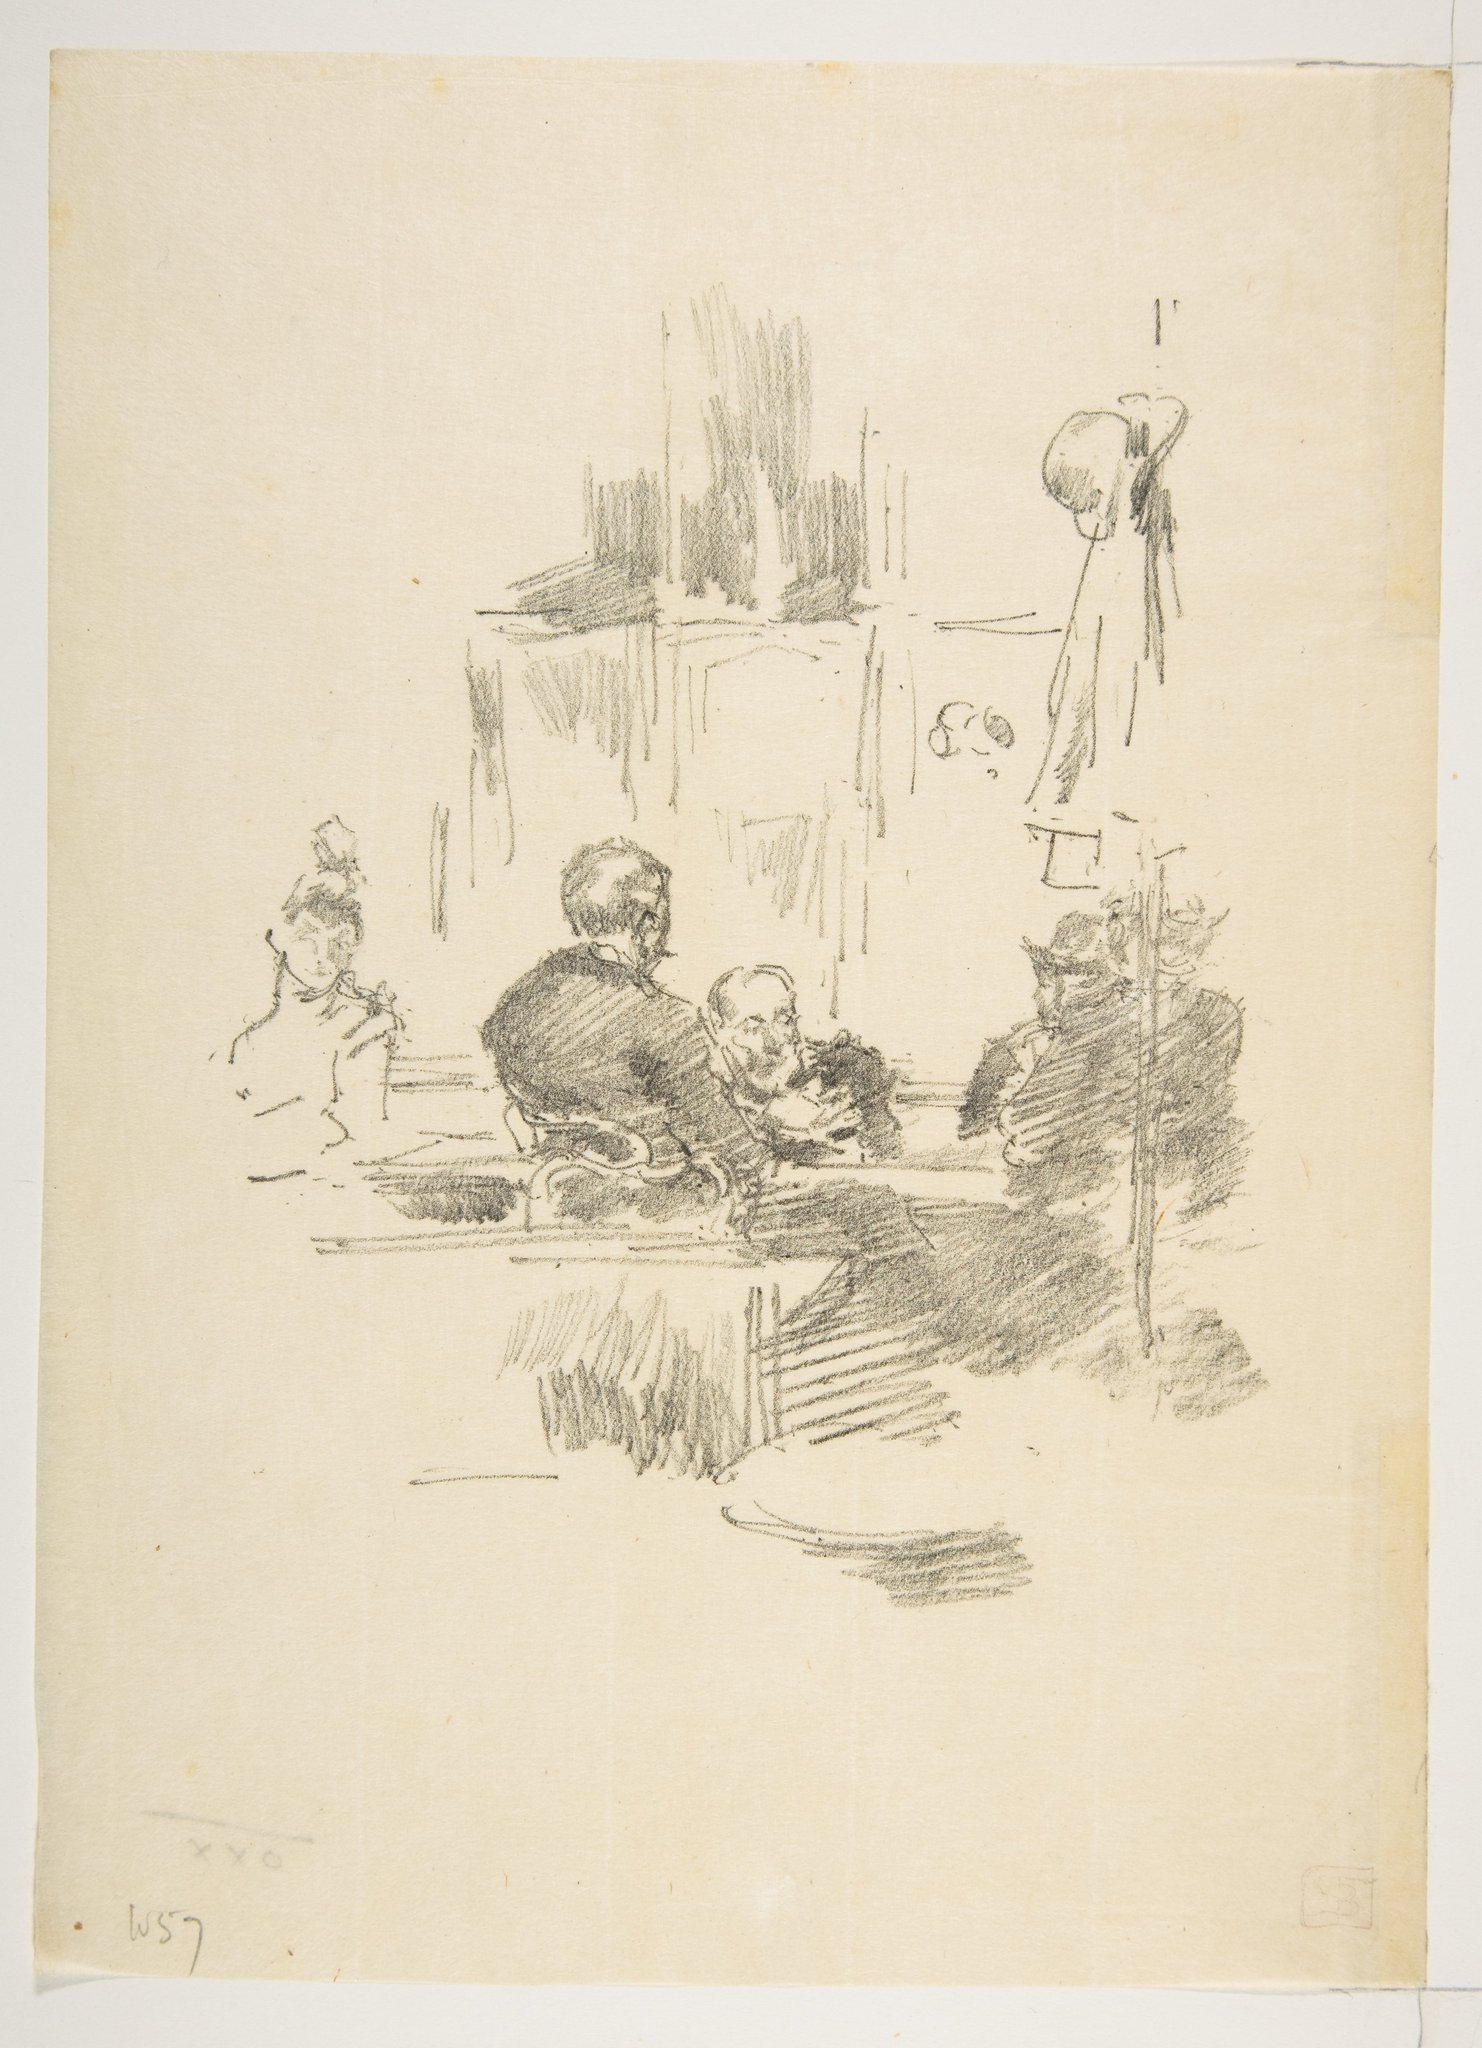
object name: print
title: Late Picquet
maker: james mcneill whistler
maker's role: artist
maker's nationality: american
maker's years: 1834-1903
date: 1890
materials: ink, paper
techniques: printing, lithography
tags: human figures